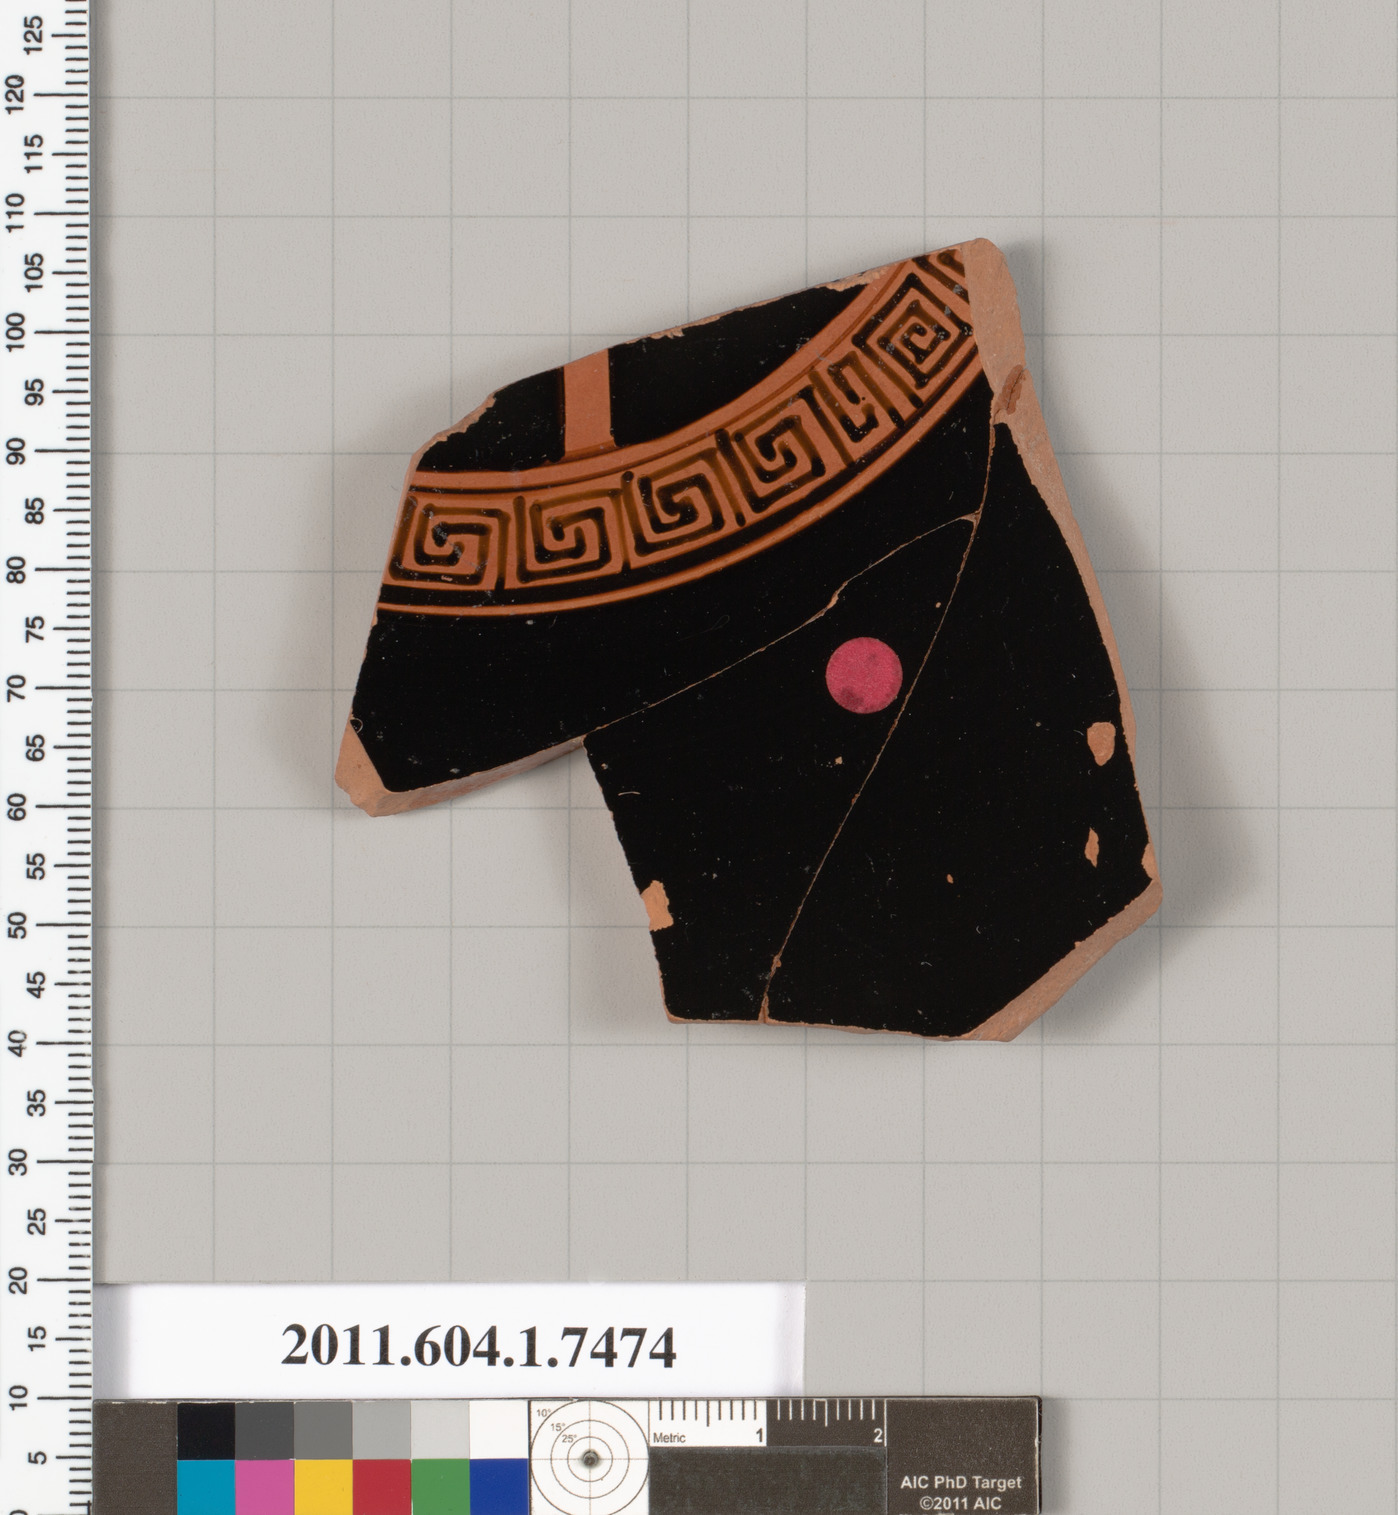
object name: kylix fragment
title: Terracotta fragment of a kylix (drinking cup)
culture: greek, attic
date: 470-460 BCE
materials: terracotta